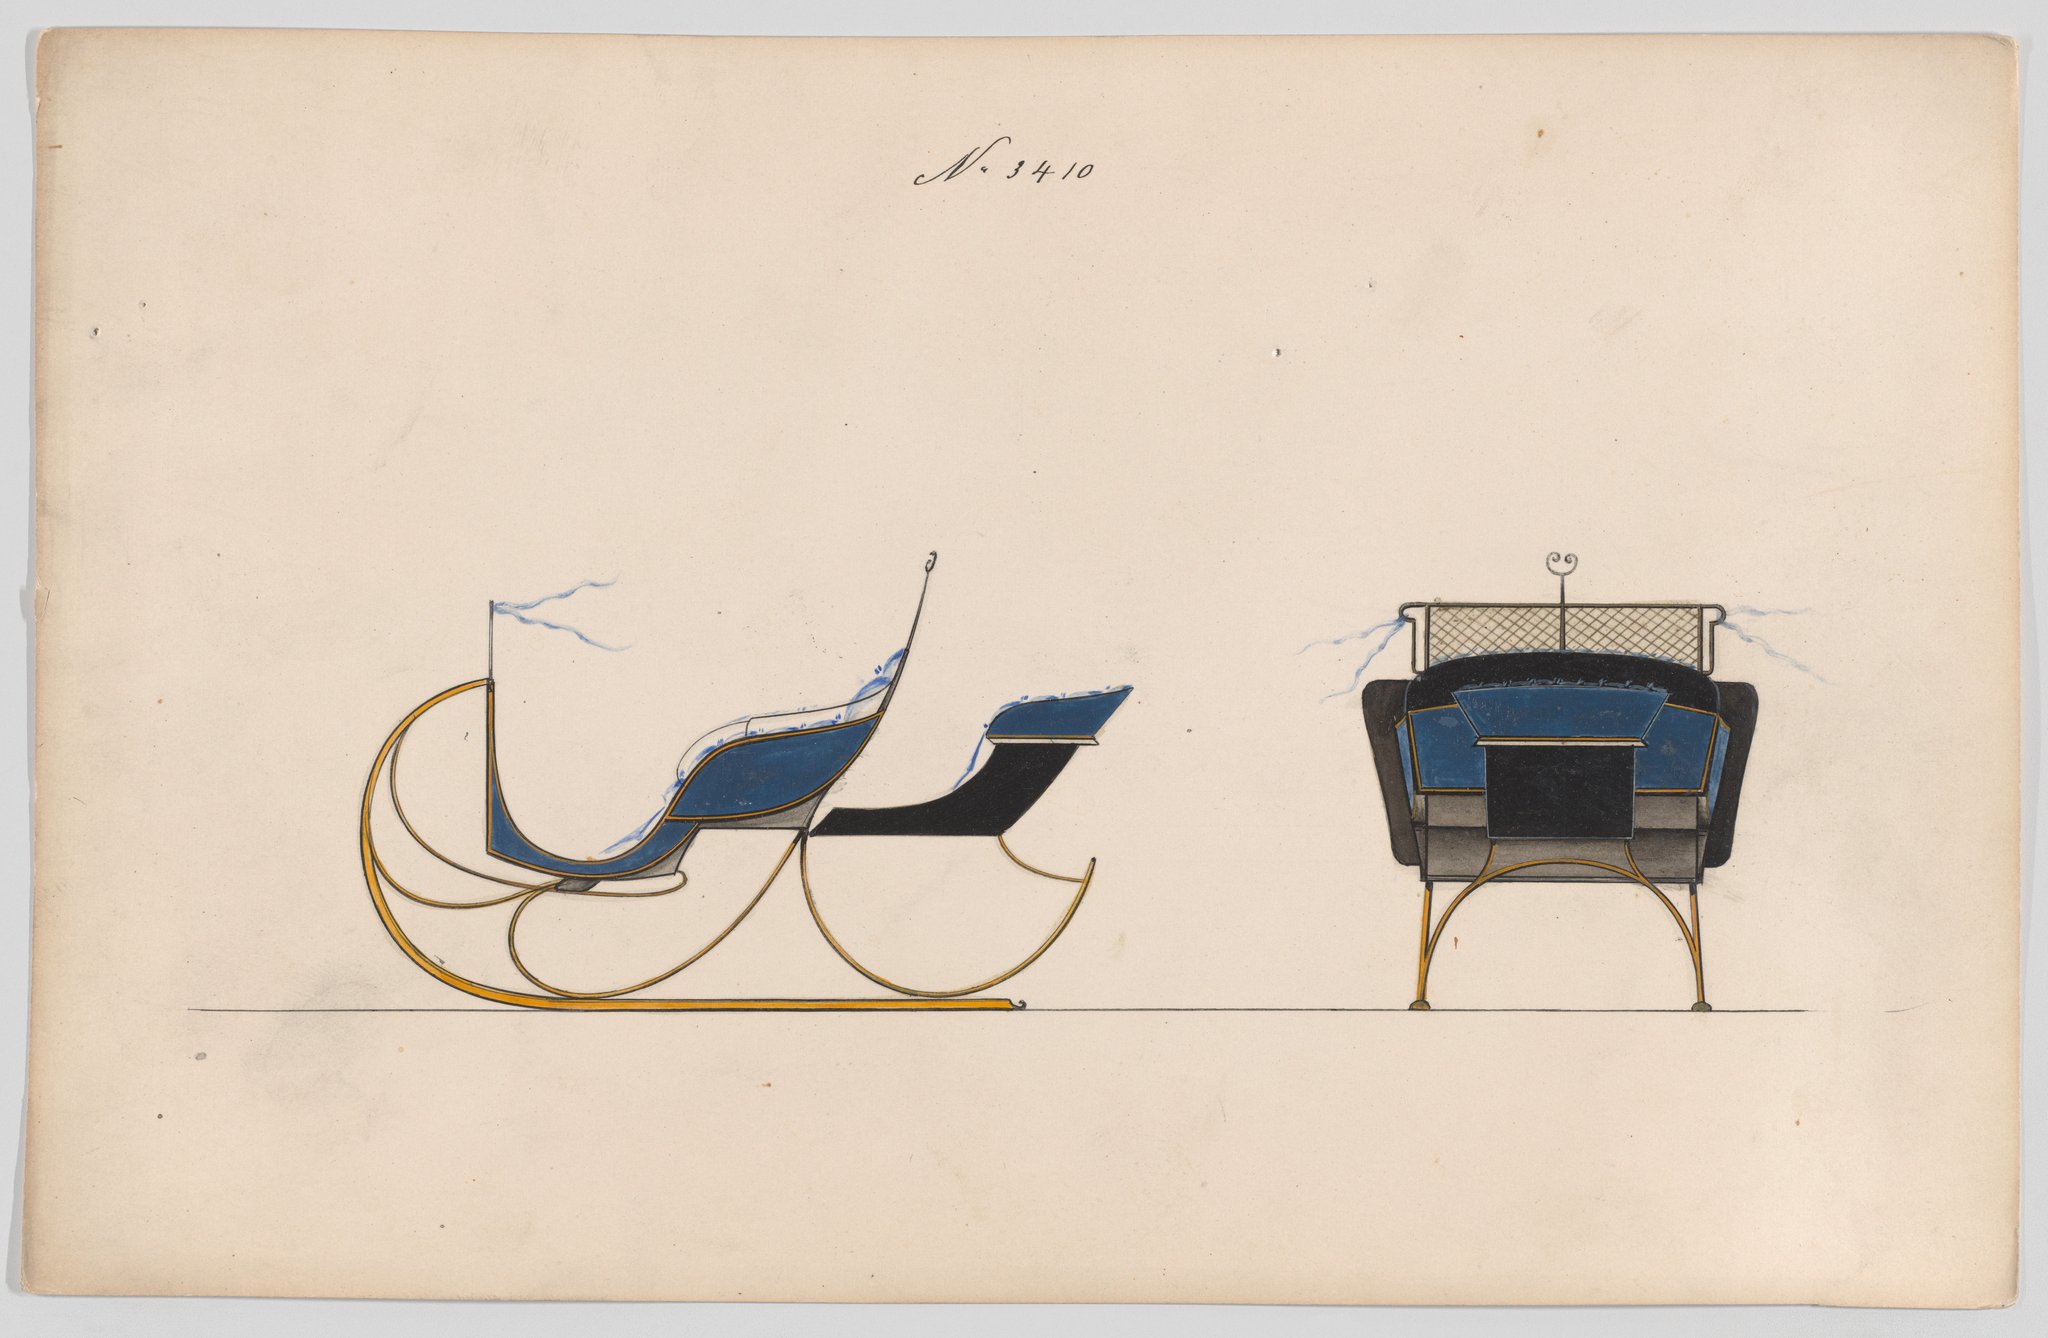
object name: drawing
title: Design for Rumble Sleigh, no. 3410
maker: brewster & co.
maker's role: manufacturer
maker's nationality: american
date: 1878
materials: gouache, gum arabic, ink, watercolor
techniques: pen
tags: sleighs